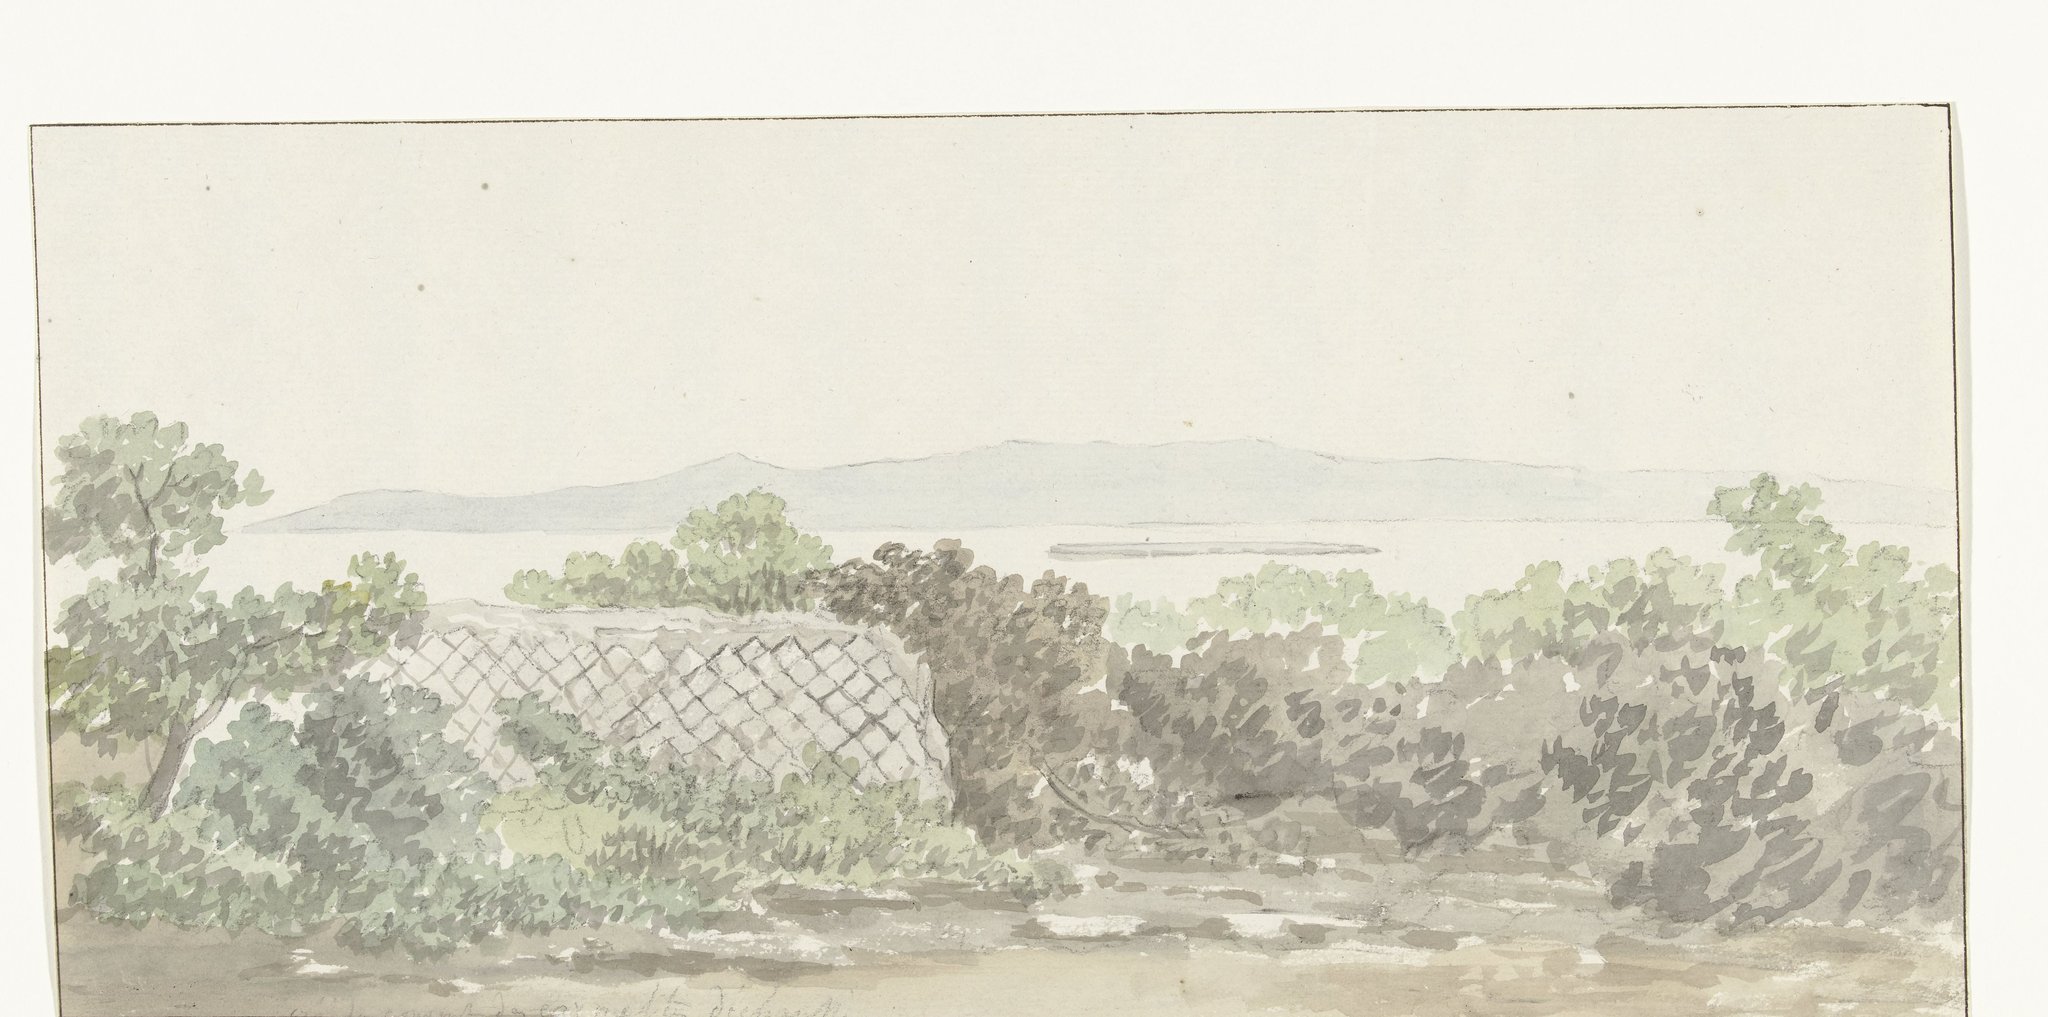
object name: drawing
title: Gezicht op de ruïne van het theater in Brindisi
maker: louis ducros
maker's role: draughtsman, print maker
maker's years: 1748-1810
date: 1778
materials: chalk, paper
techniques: brush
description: Tekening uit het album 'Voyage en Italie, en Sicile et à Malte', 1778.